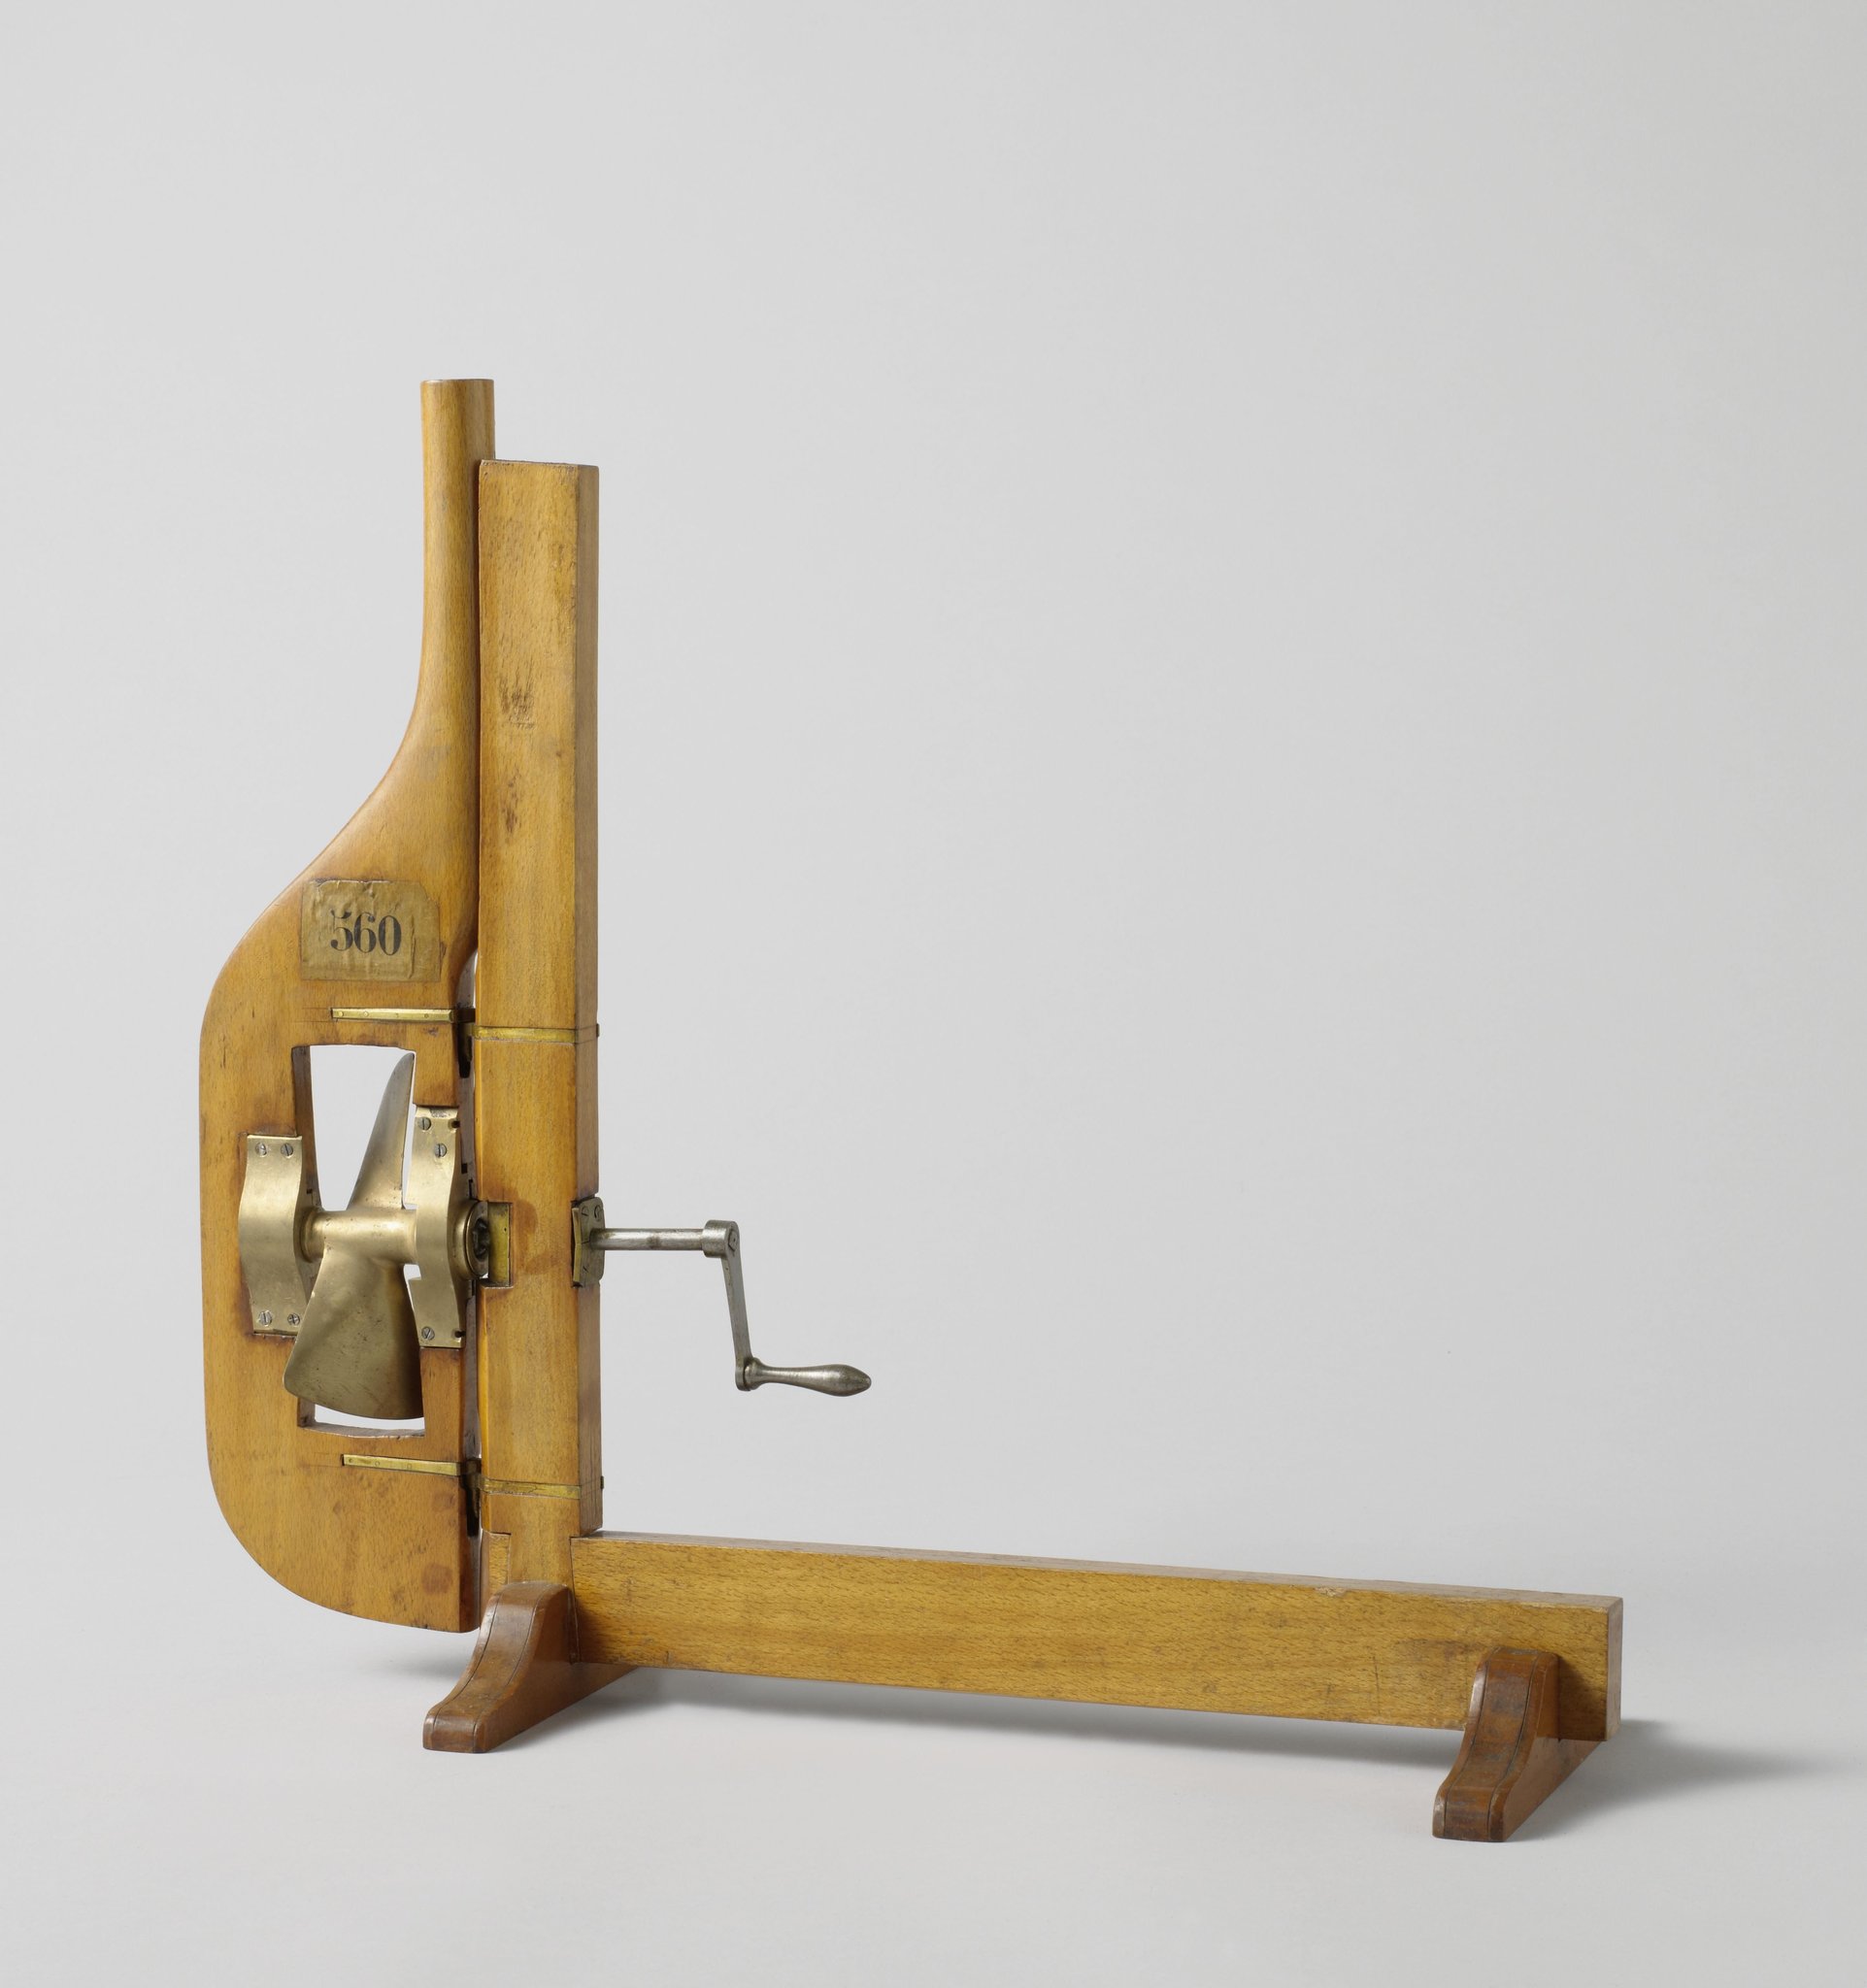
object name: demonstration model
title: Model of a Rudder and Screw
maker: a. sol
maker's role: ship modeller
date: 1850-1858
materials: brass, iron, wood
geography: flushing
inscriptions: label, on the rifle: ‘560’ former inventory label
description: Model van een roer met ronde roerkoning en schroef aan een achtersteven met deel van de kiel. Het roerblad dient als schroefraam voor de gewone tweebladige schroef, die hierdoor met het roer meedraait. De schroefas is voorzien van een kruiskoppeling tussen achtersteven en roer, zodat de beweging van de schroefas kan worden overgebracht op de schroef ongeacht de stand van het roer. De schroefas kan met een zwengel worden aangedreven.